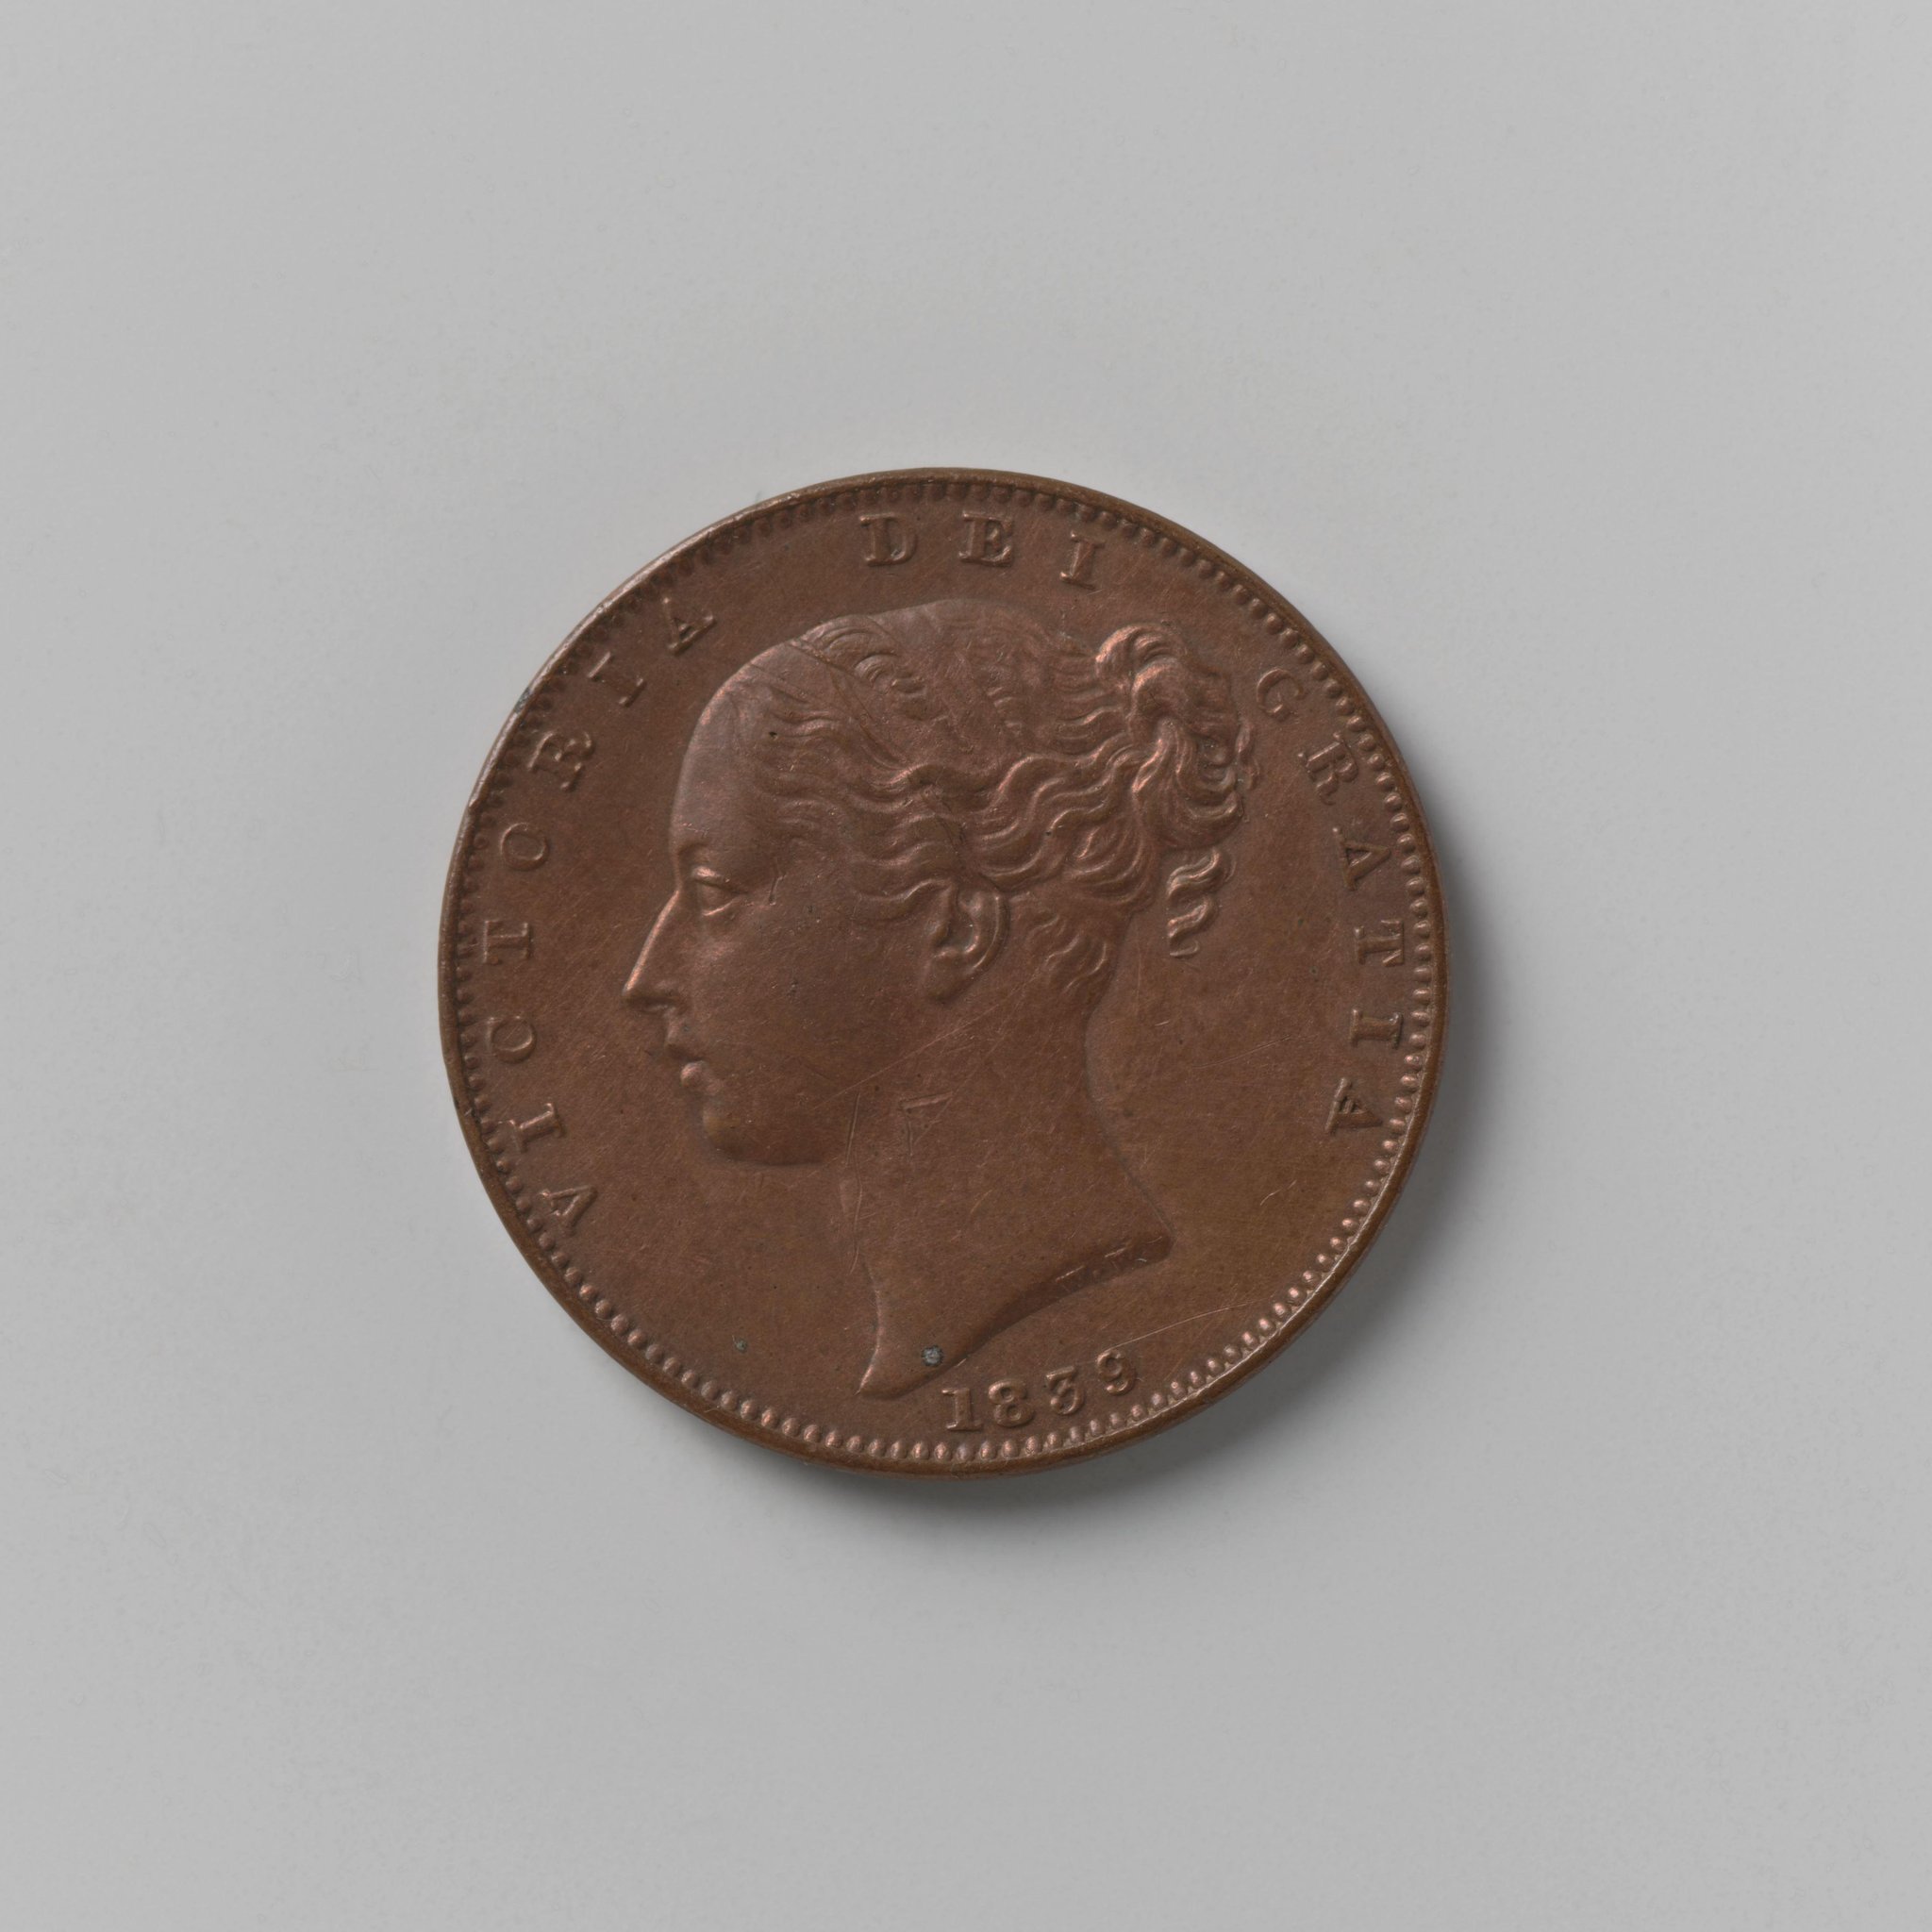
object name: coin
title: Engeland, Victoria, farthing, 1839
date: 1839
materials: copper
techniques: striking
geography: london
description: Koperen munt. Voorzijde: hoofd van de koningin naar links [young head]. Jaartal onderaan. Keerzijde: tegen wapenschild gezeten Brittannia met drietand, naar rechts. In afsnede klaverblad, roos en distel. Gladde rand.